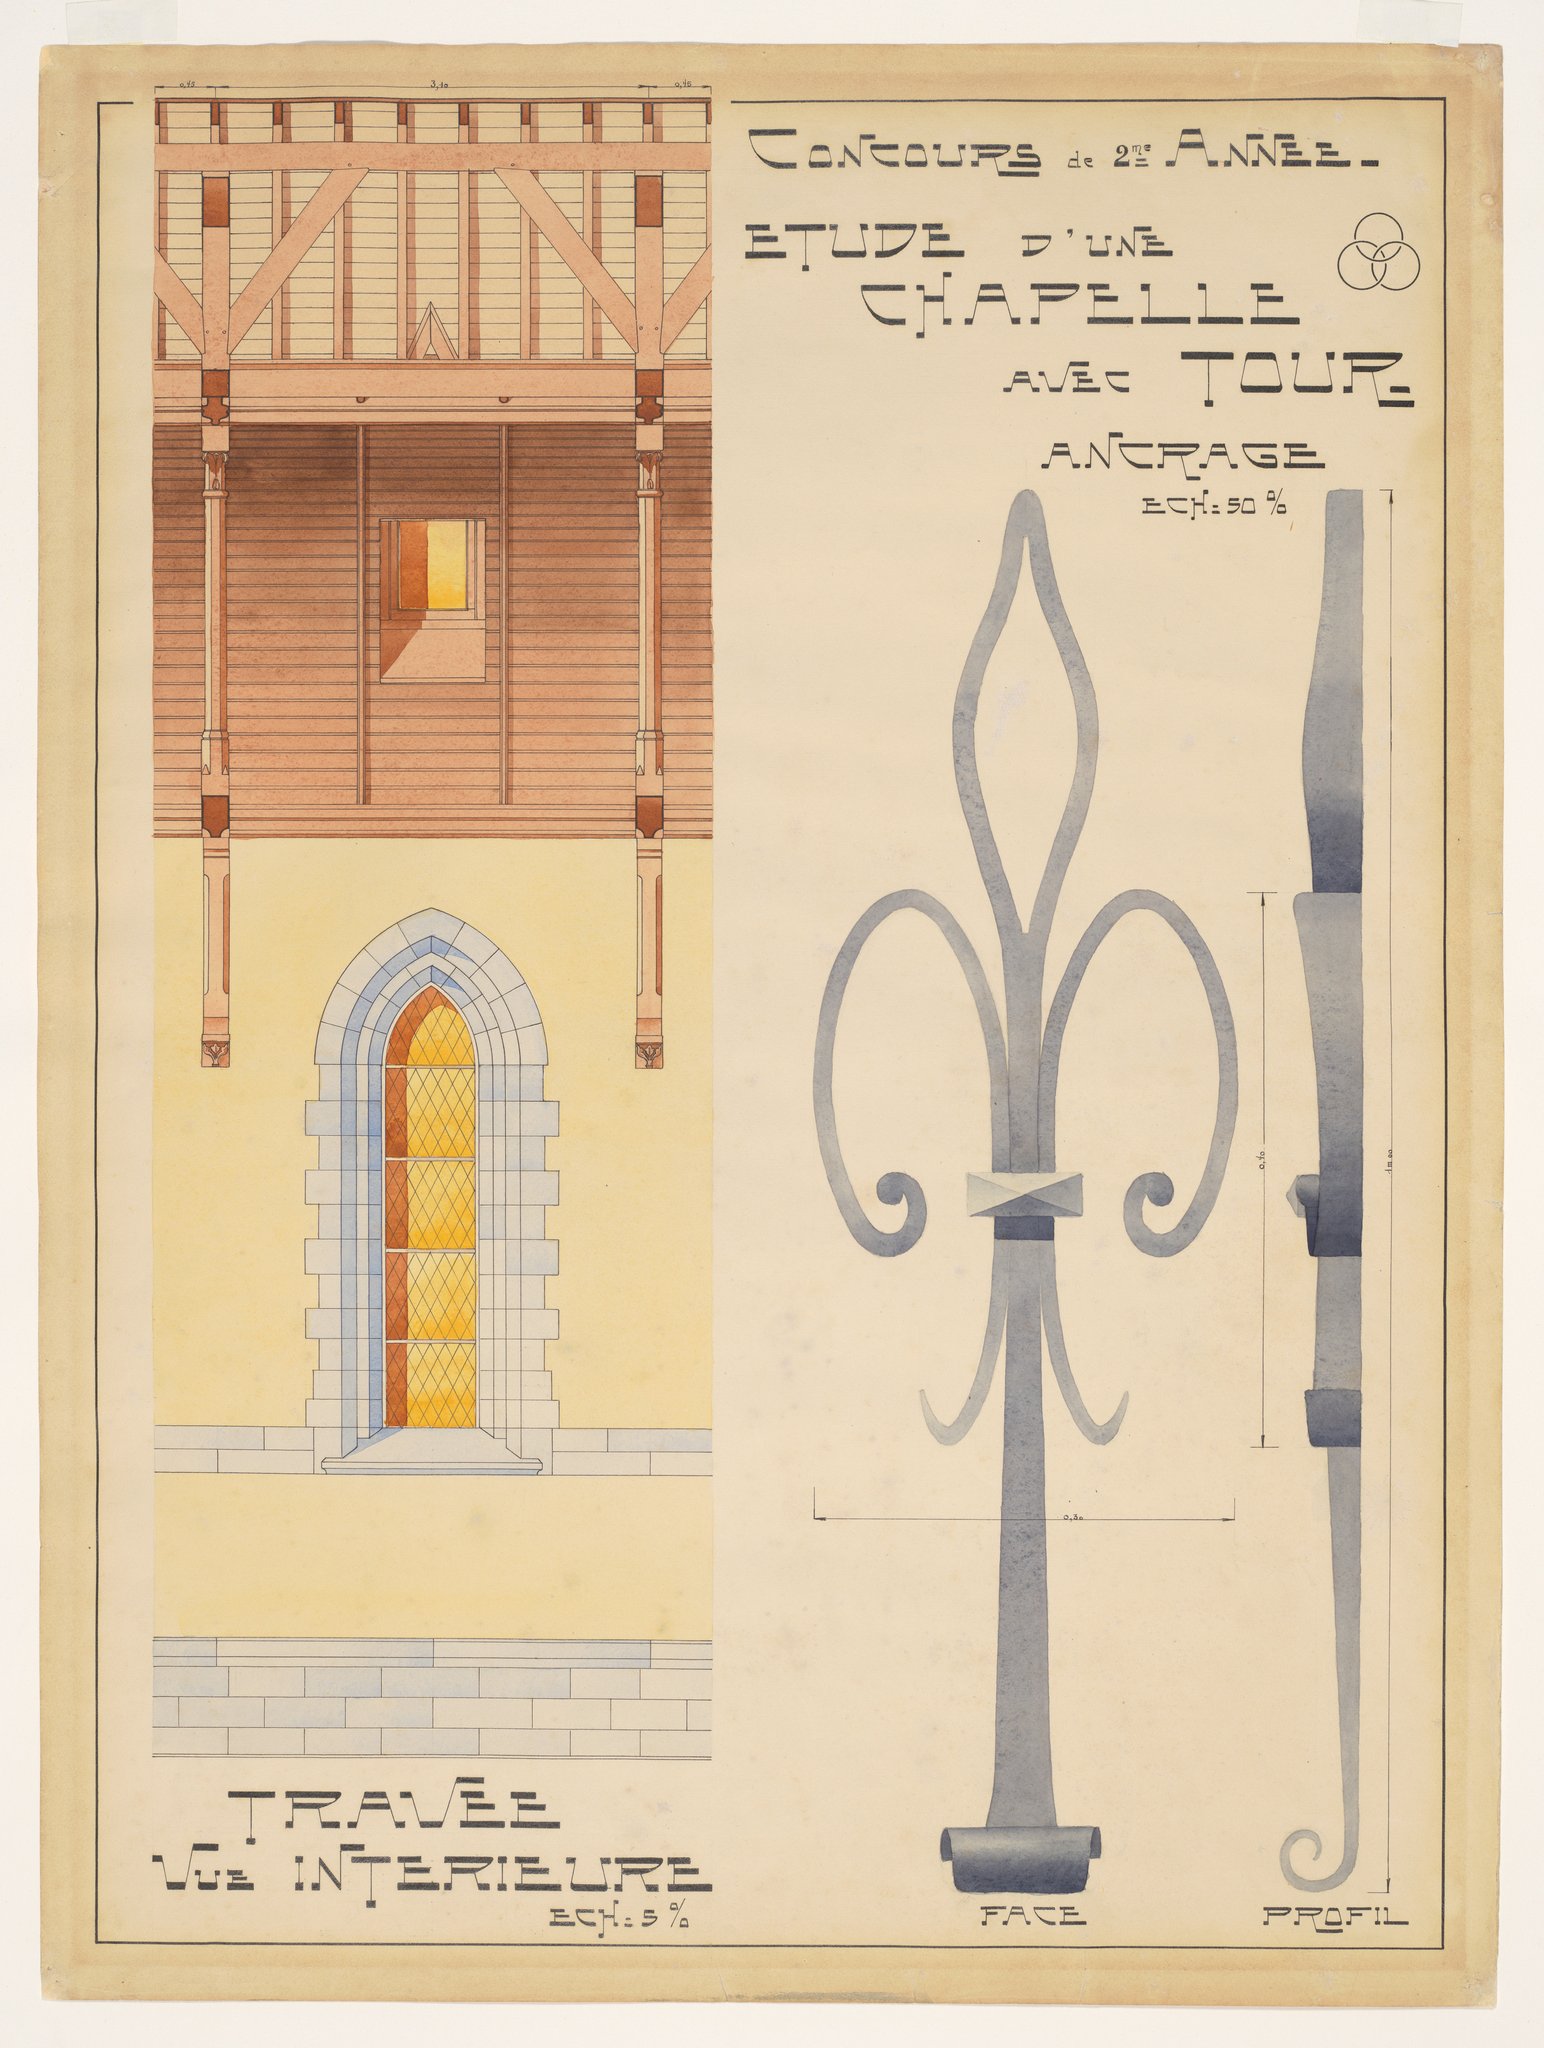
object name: drawing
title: Second Year Competition Drawing for a Chapel with a Tower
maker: r. de clerck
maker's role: artist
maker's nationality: belgian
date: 1900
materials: graphite, ink, watercolor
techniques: pen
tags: architecture